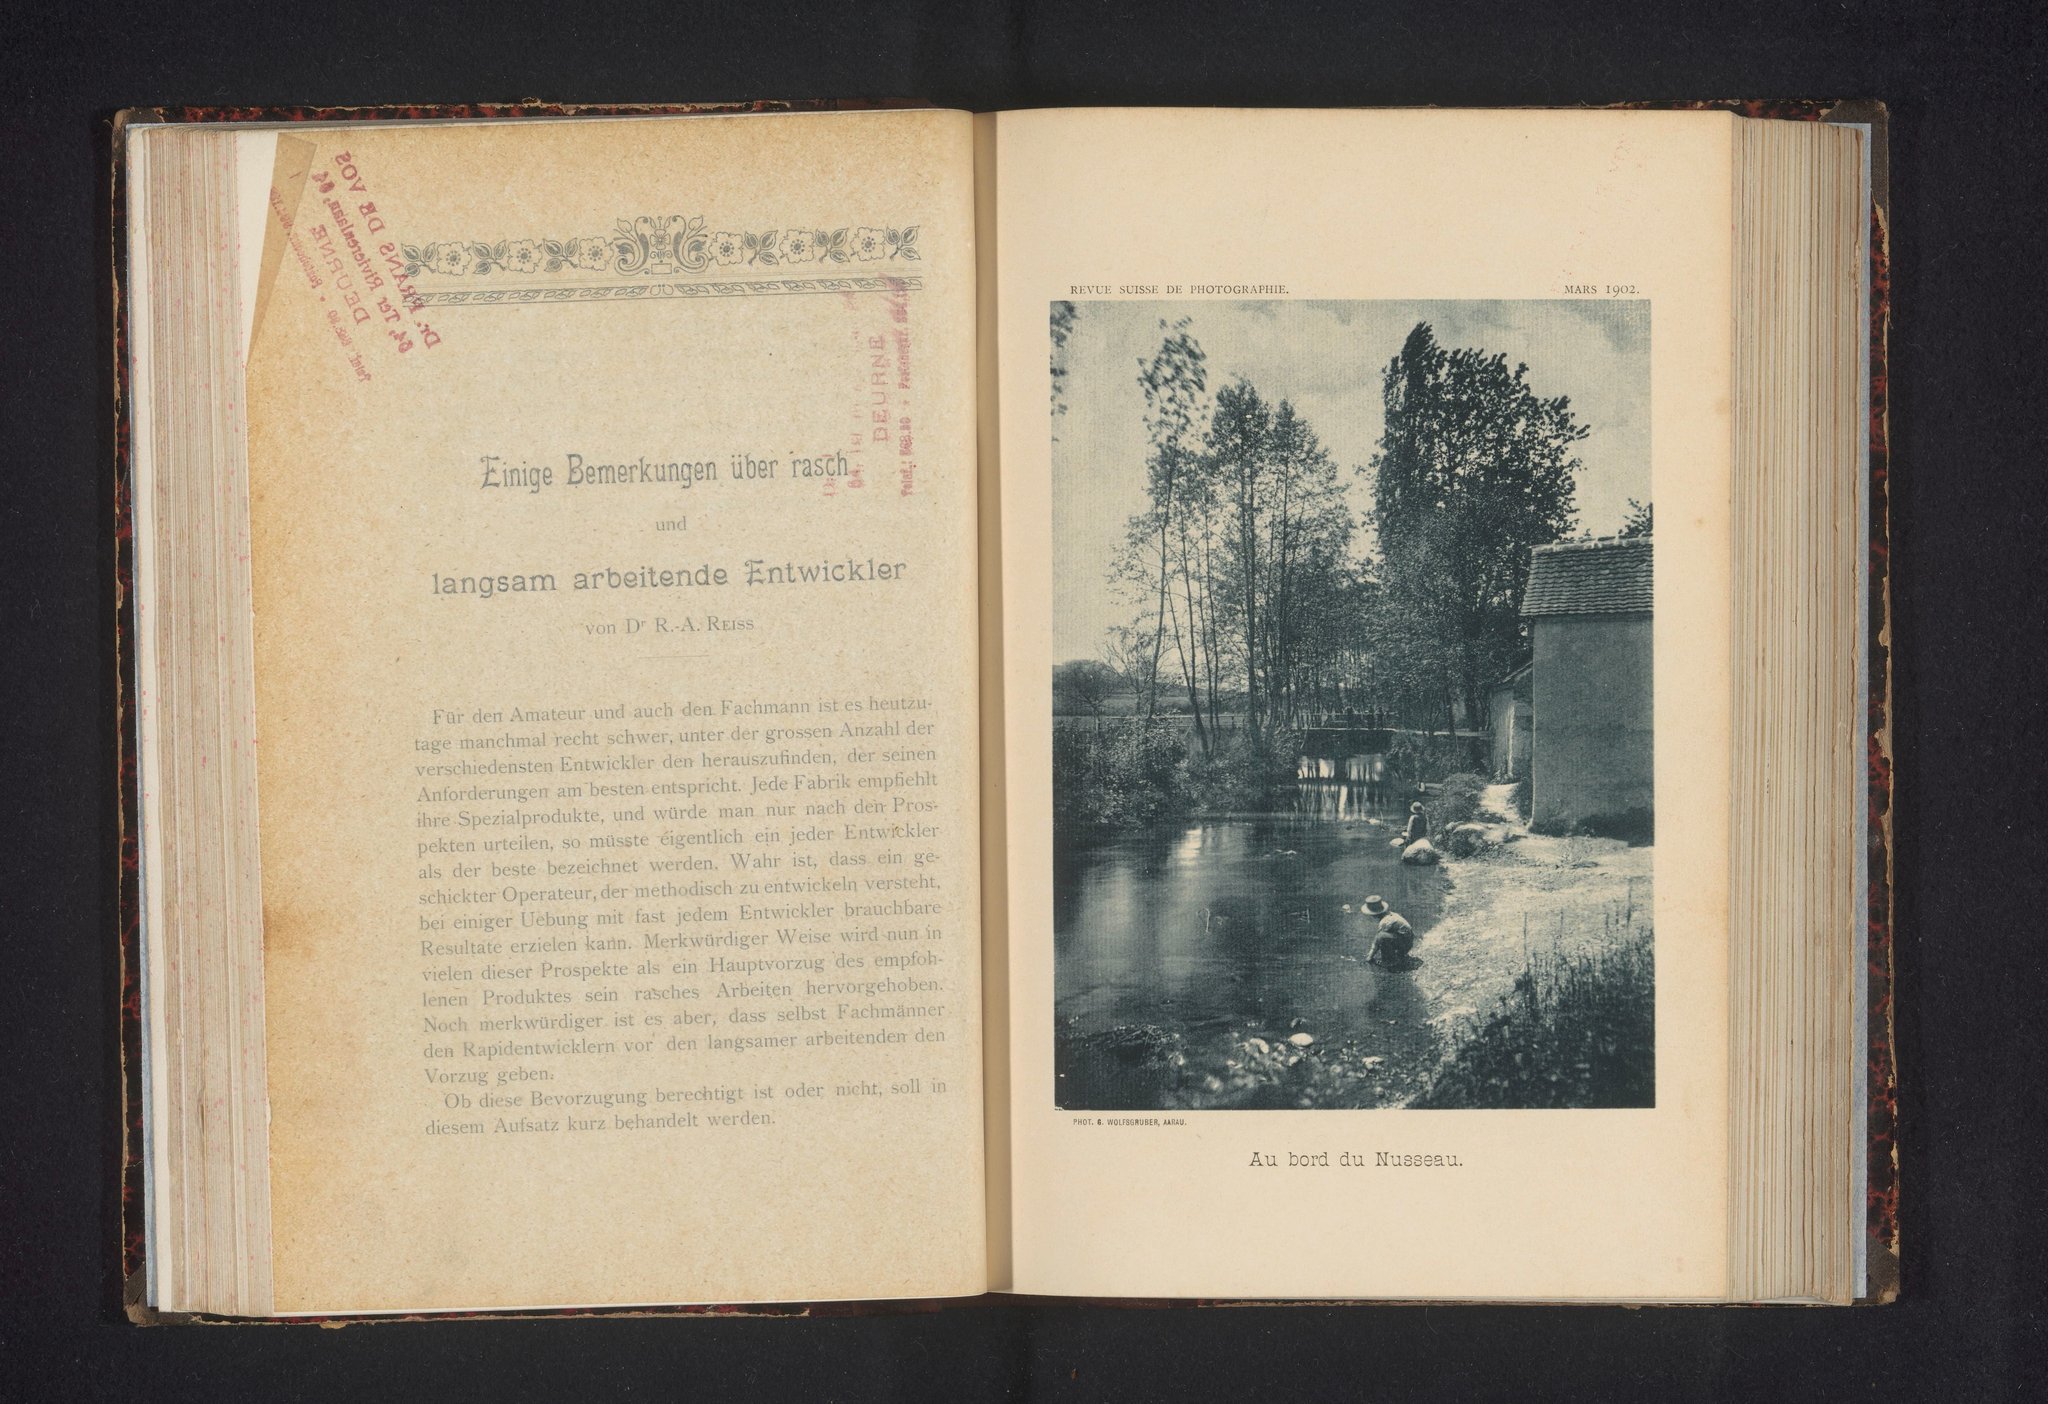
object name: page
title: Gezicht op een rivier met spelende kinderen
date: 1897-1902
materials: paper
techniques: photograph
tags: river, child